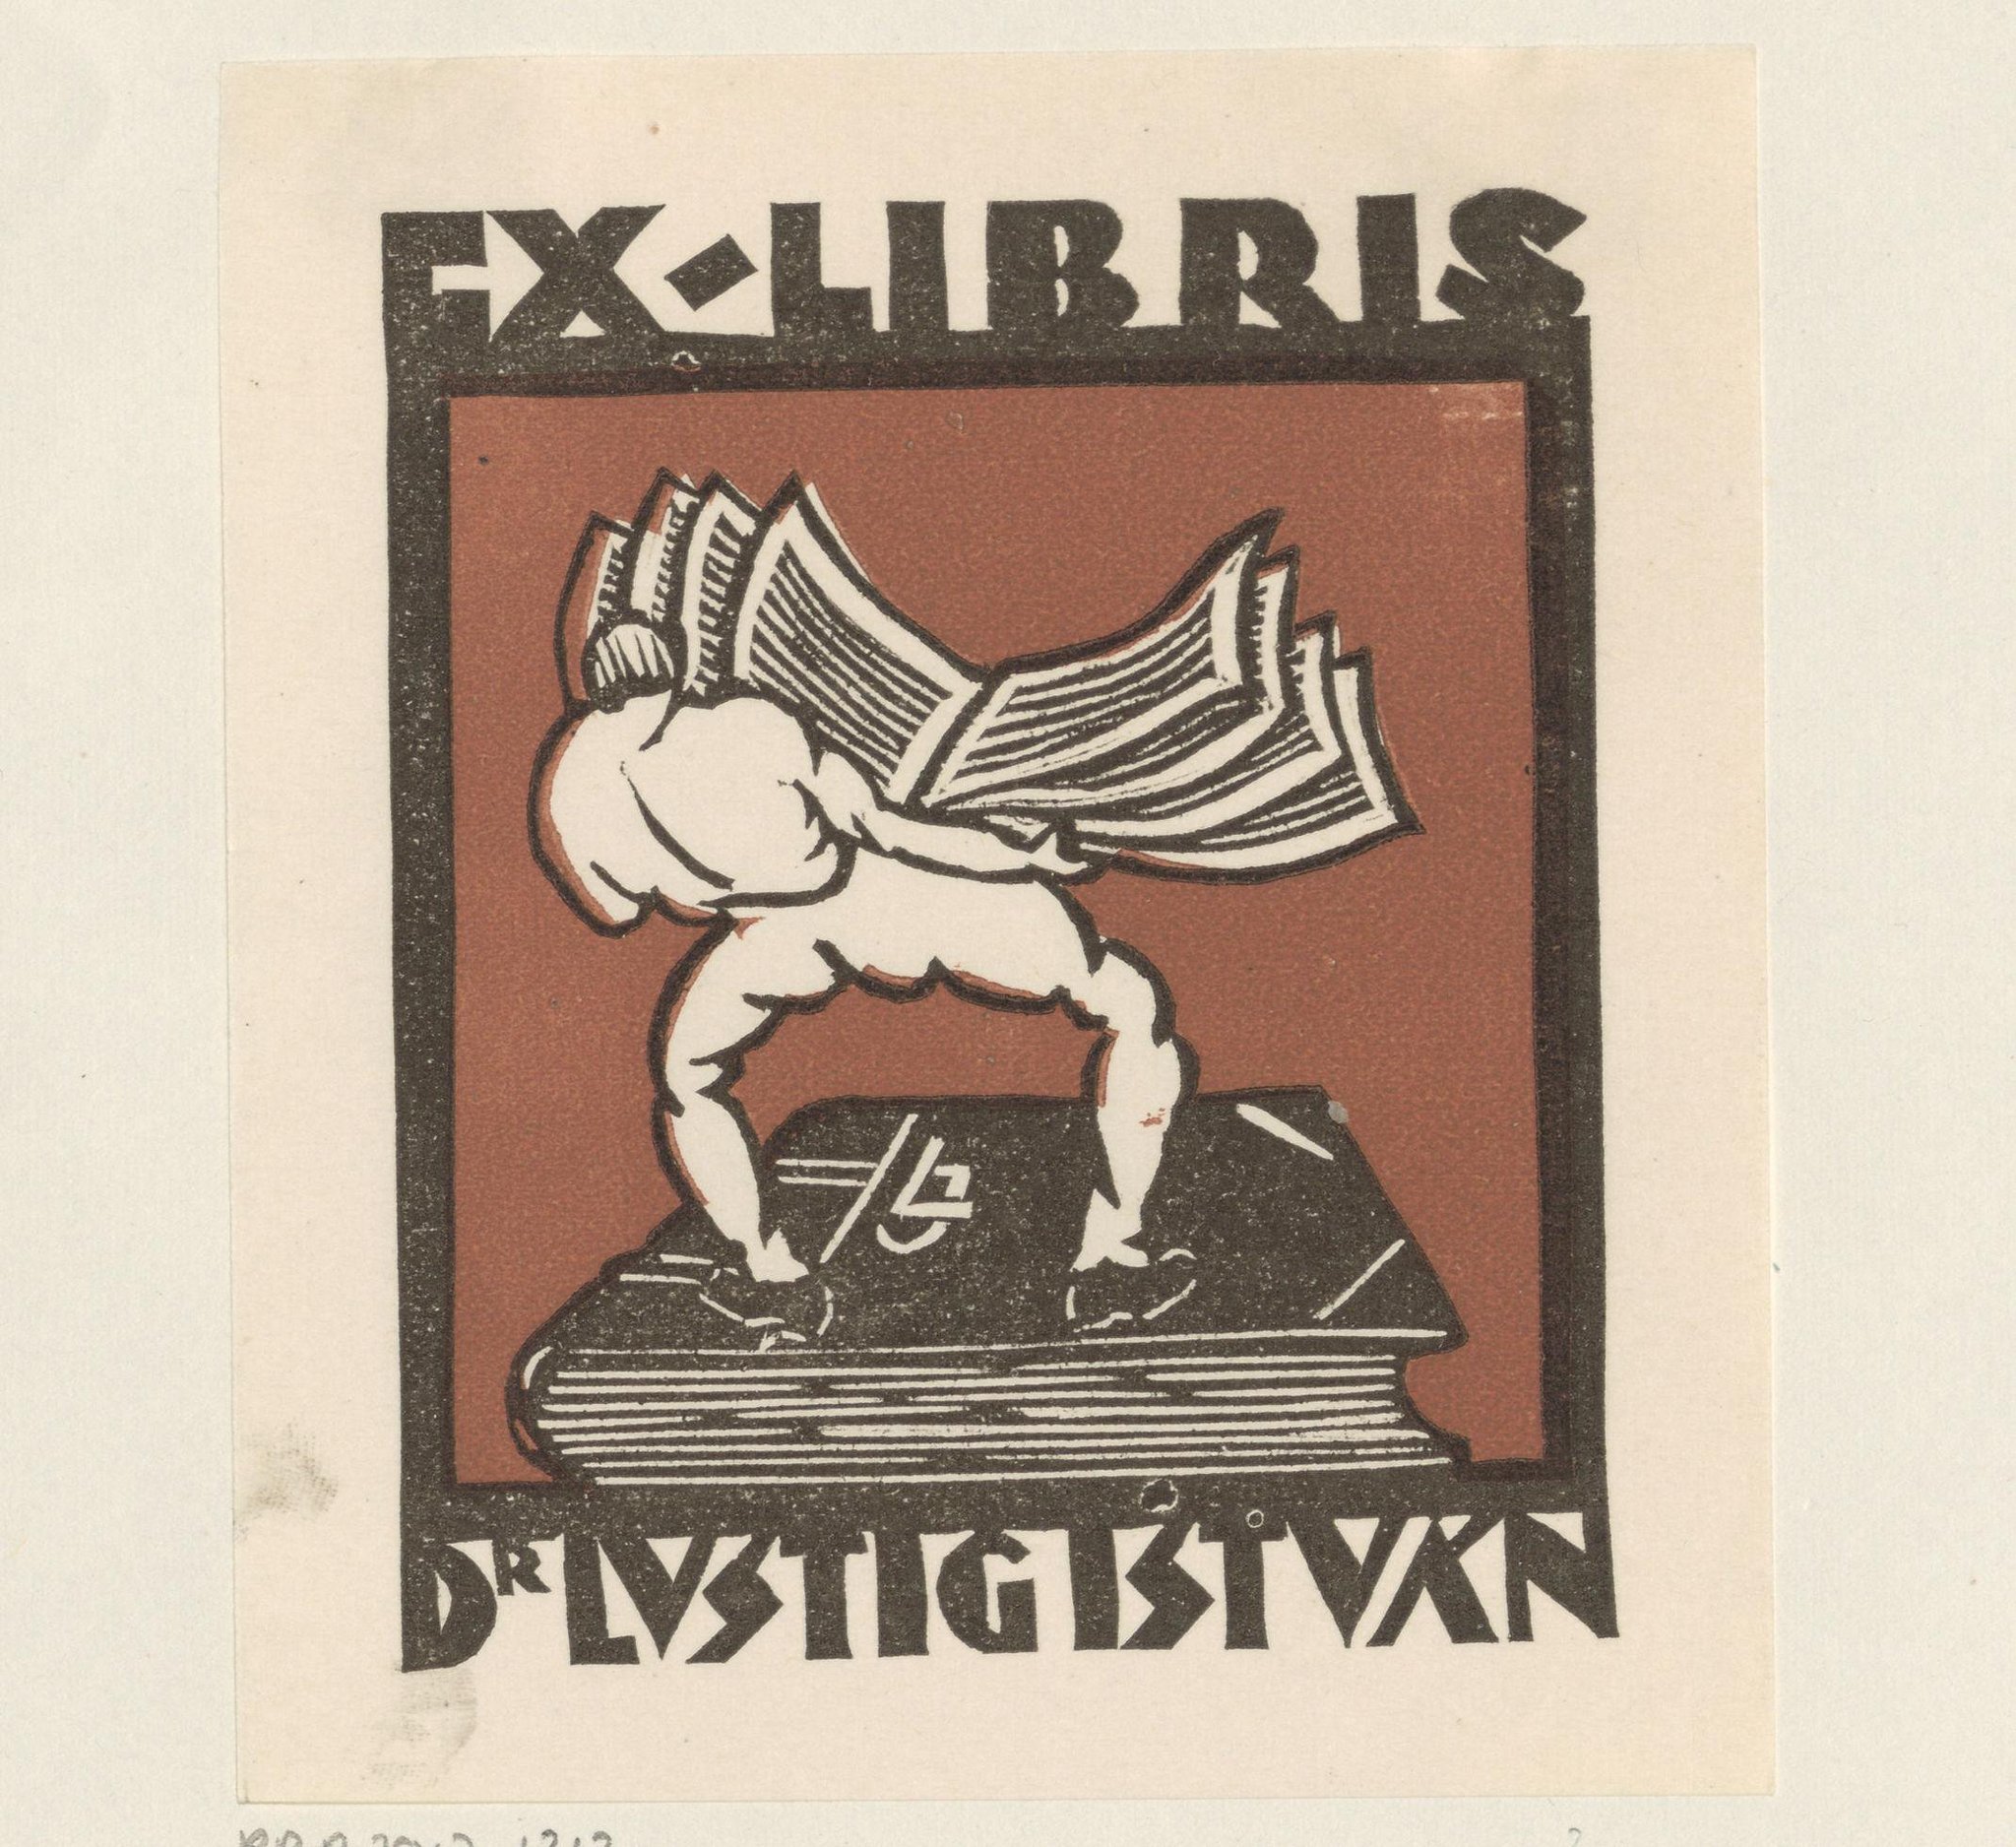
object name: bookplate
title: Ex libris van István Lustig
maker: Anonymous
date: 1913-1944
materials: paper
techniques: linocut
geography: hungary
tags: reading, weight lifting, book, man (showing himself) undressed, quasi-nude